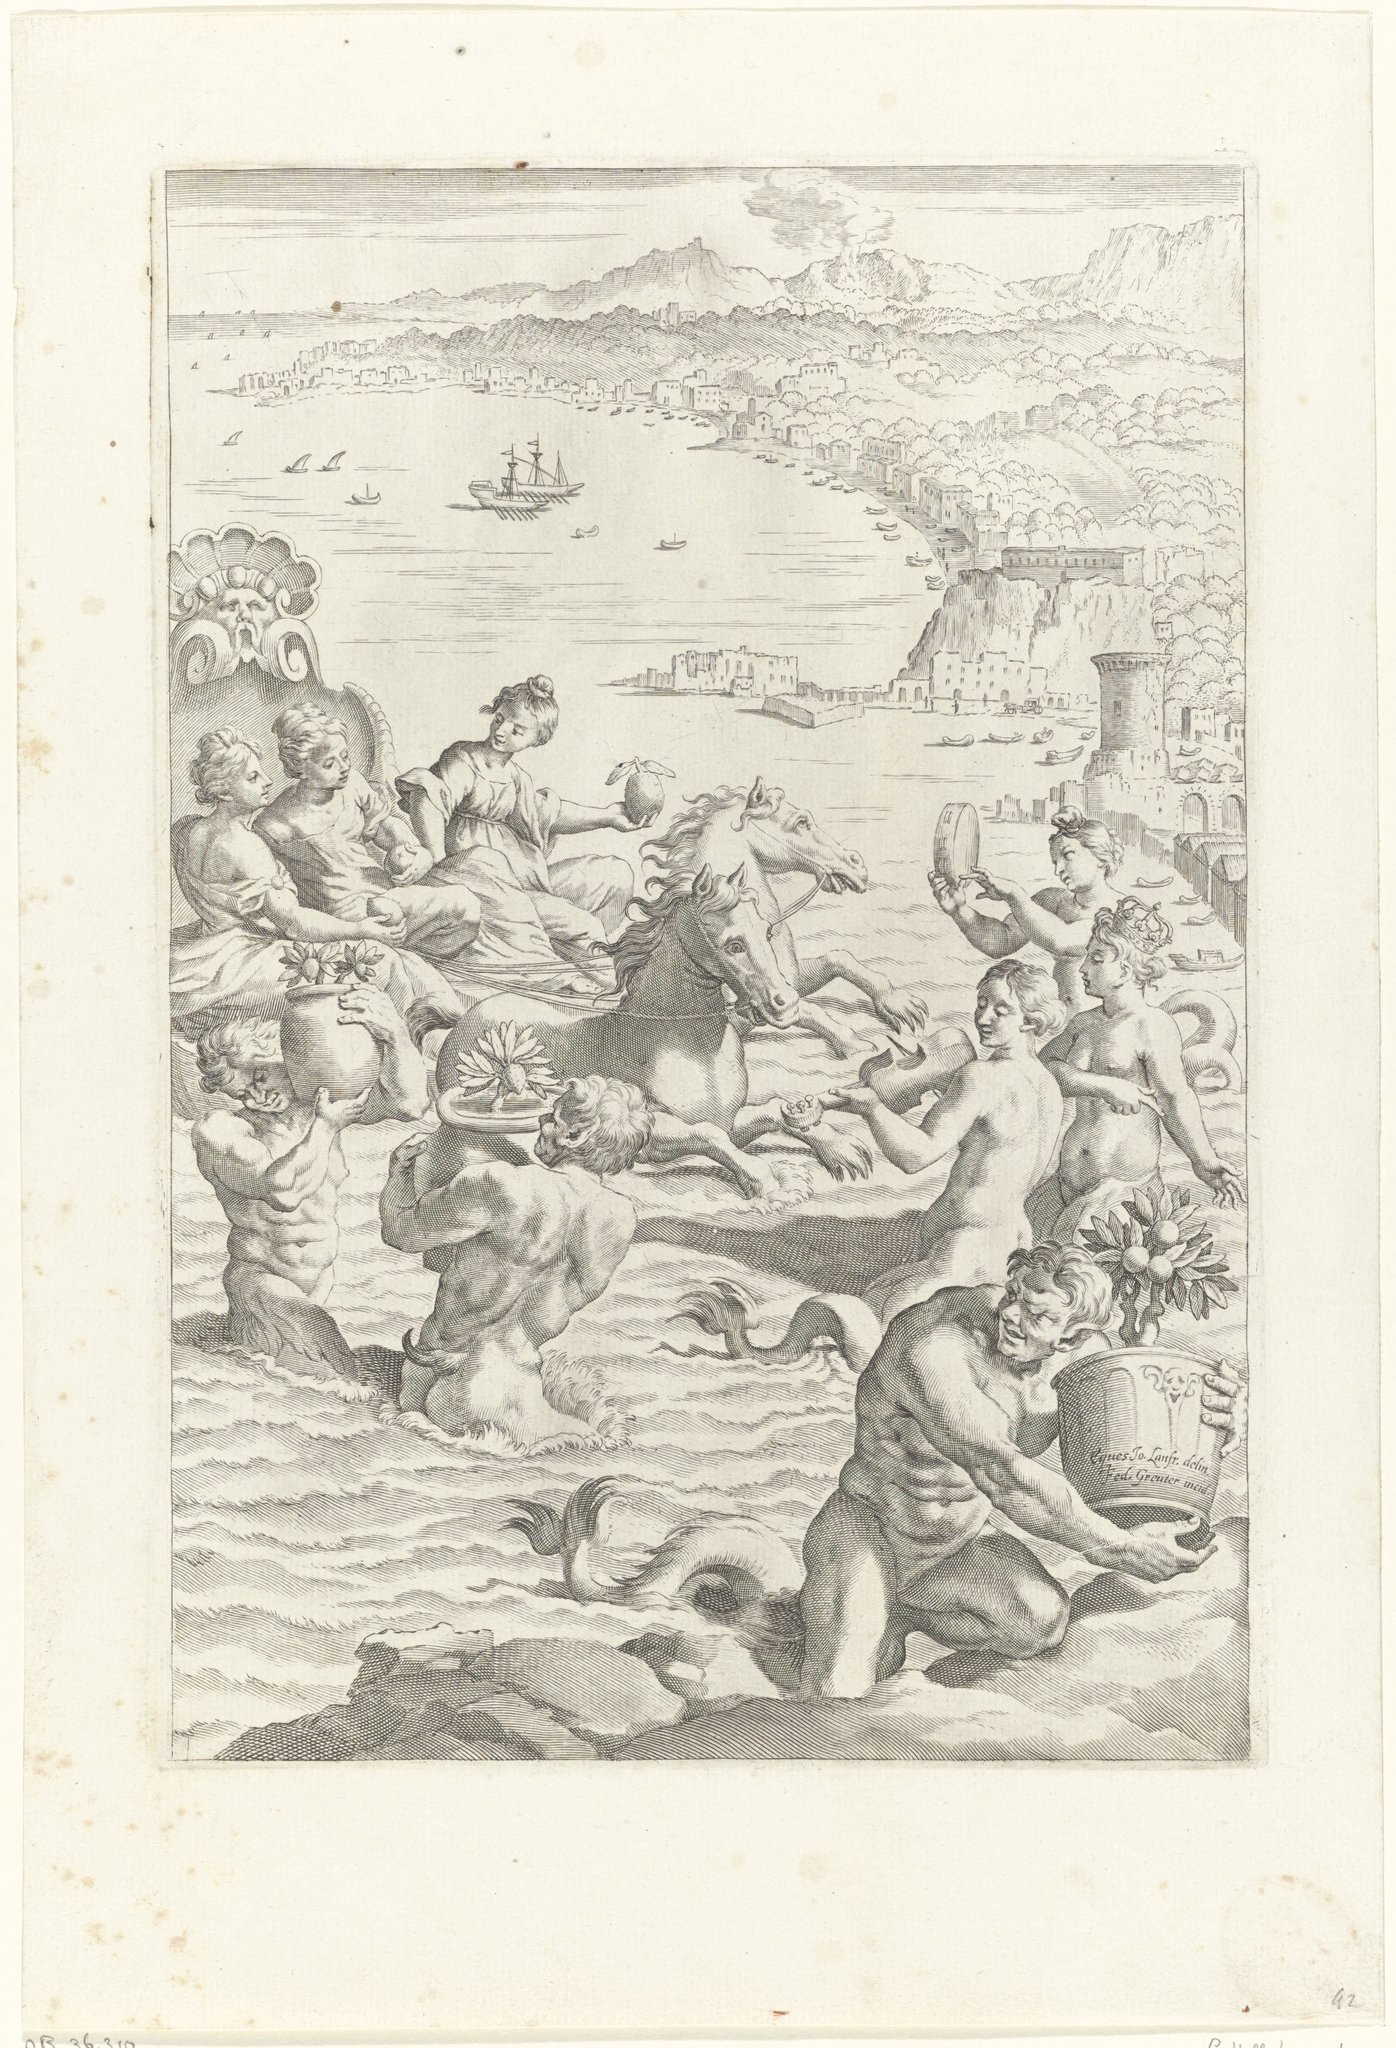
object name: print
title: Aankomst van de Hesperiden te Napels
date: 1646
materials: paper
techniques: engraving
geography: italy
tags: triton(s), merman - aa - mermaid, siren, the hesperides, guardians of the tree with golden apples, mount vesuvius, naples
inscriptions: collector's mark: Lugt 240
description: De Hesperiden, op een wagen voortgetrokken door hippocampussen, arriveren te Napels na een reis over zee. Ze worden omringd door tritons met potten met appelbomen en meerminnen met muziekinstrumenten. Op de achtergrond de baai van Napels en de Vesivius.